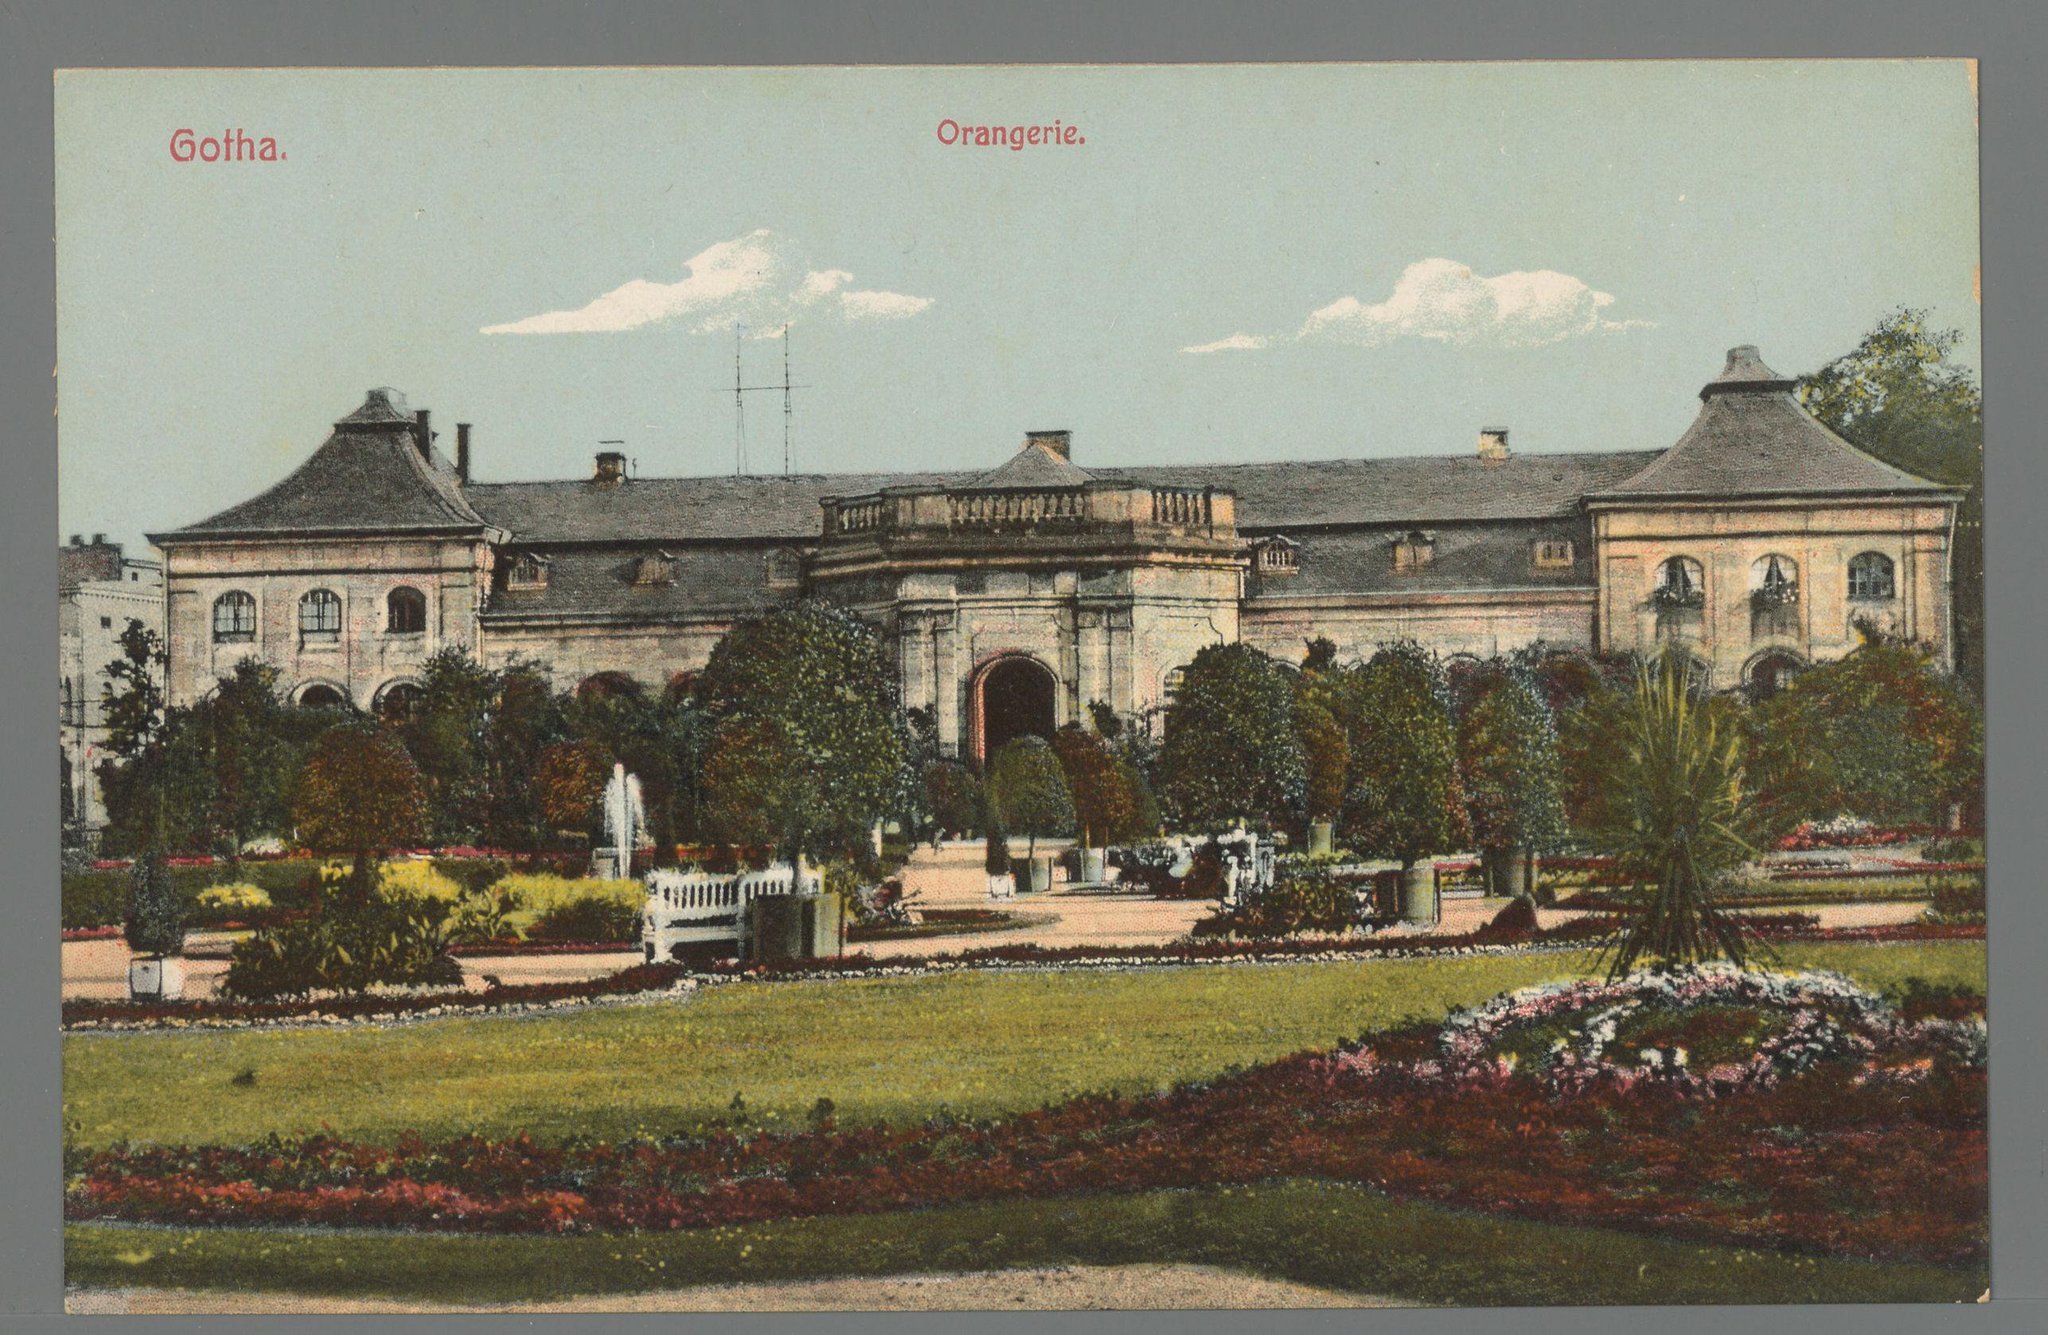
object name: ansichtkaart, prentbriefkaart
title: Gotha. Orangerie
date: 1905-1930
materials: cardboard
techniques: photograph, lithograph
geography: gotha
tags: greenhouse, orangery